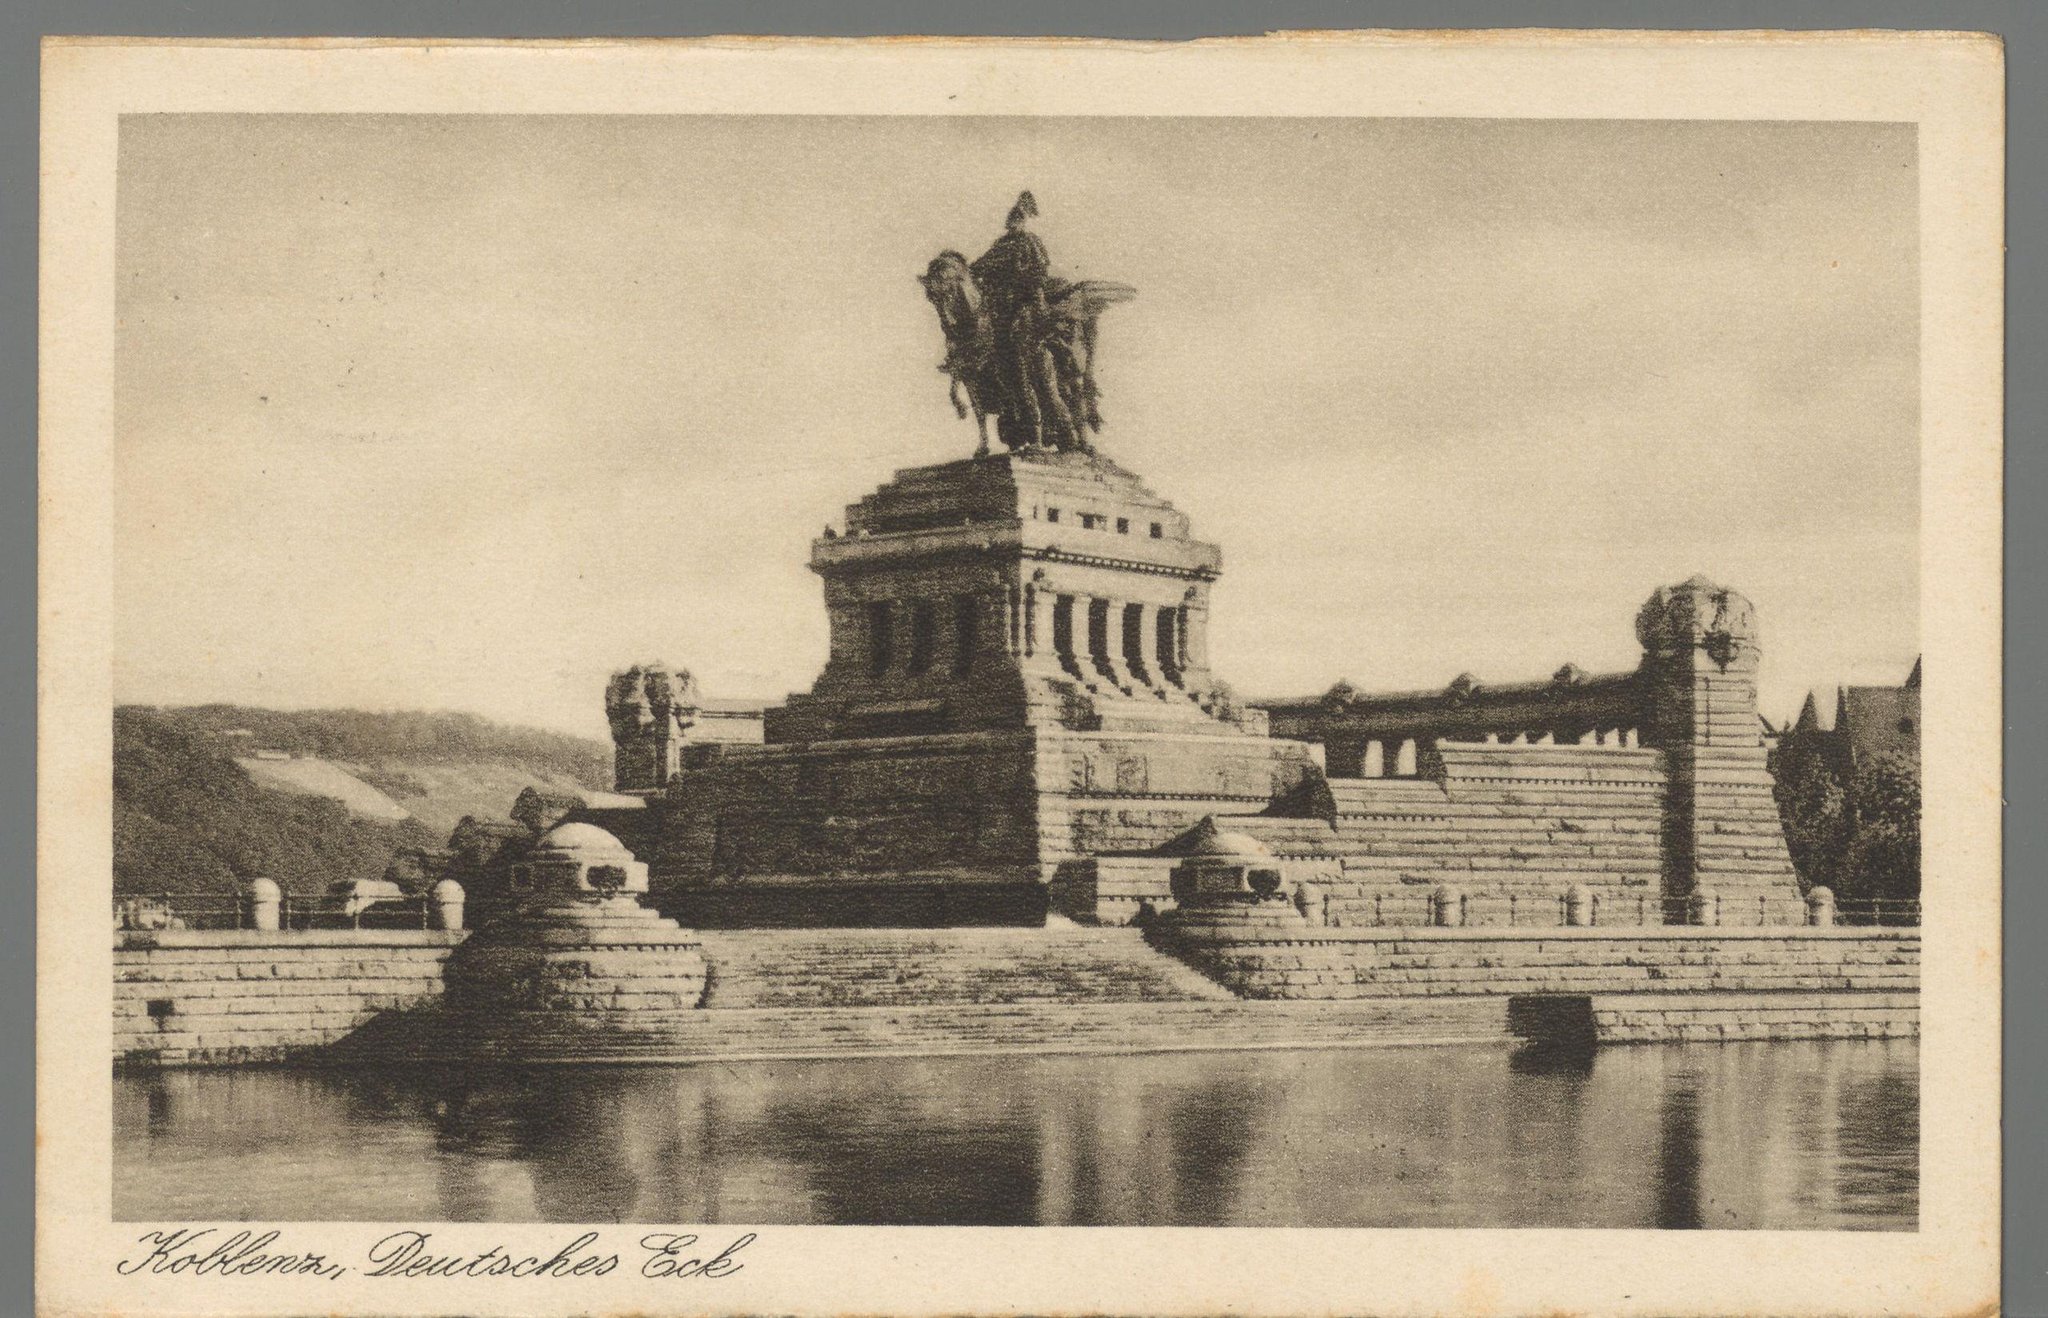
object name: ansichtkaart, prentbriefkaart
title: Koblenz, Deutsches Eck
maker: Anonymous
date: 1895-1939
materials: cardboard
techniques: rotogravure, writing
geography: cologne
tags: landscape with monument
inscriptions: poststempel, verso, gestempeld